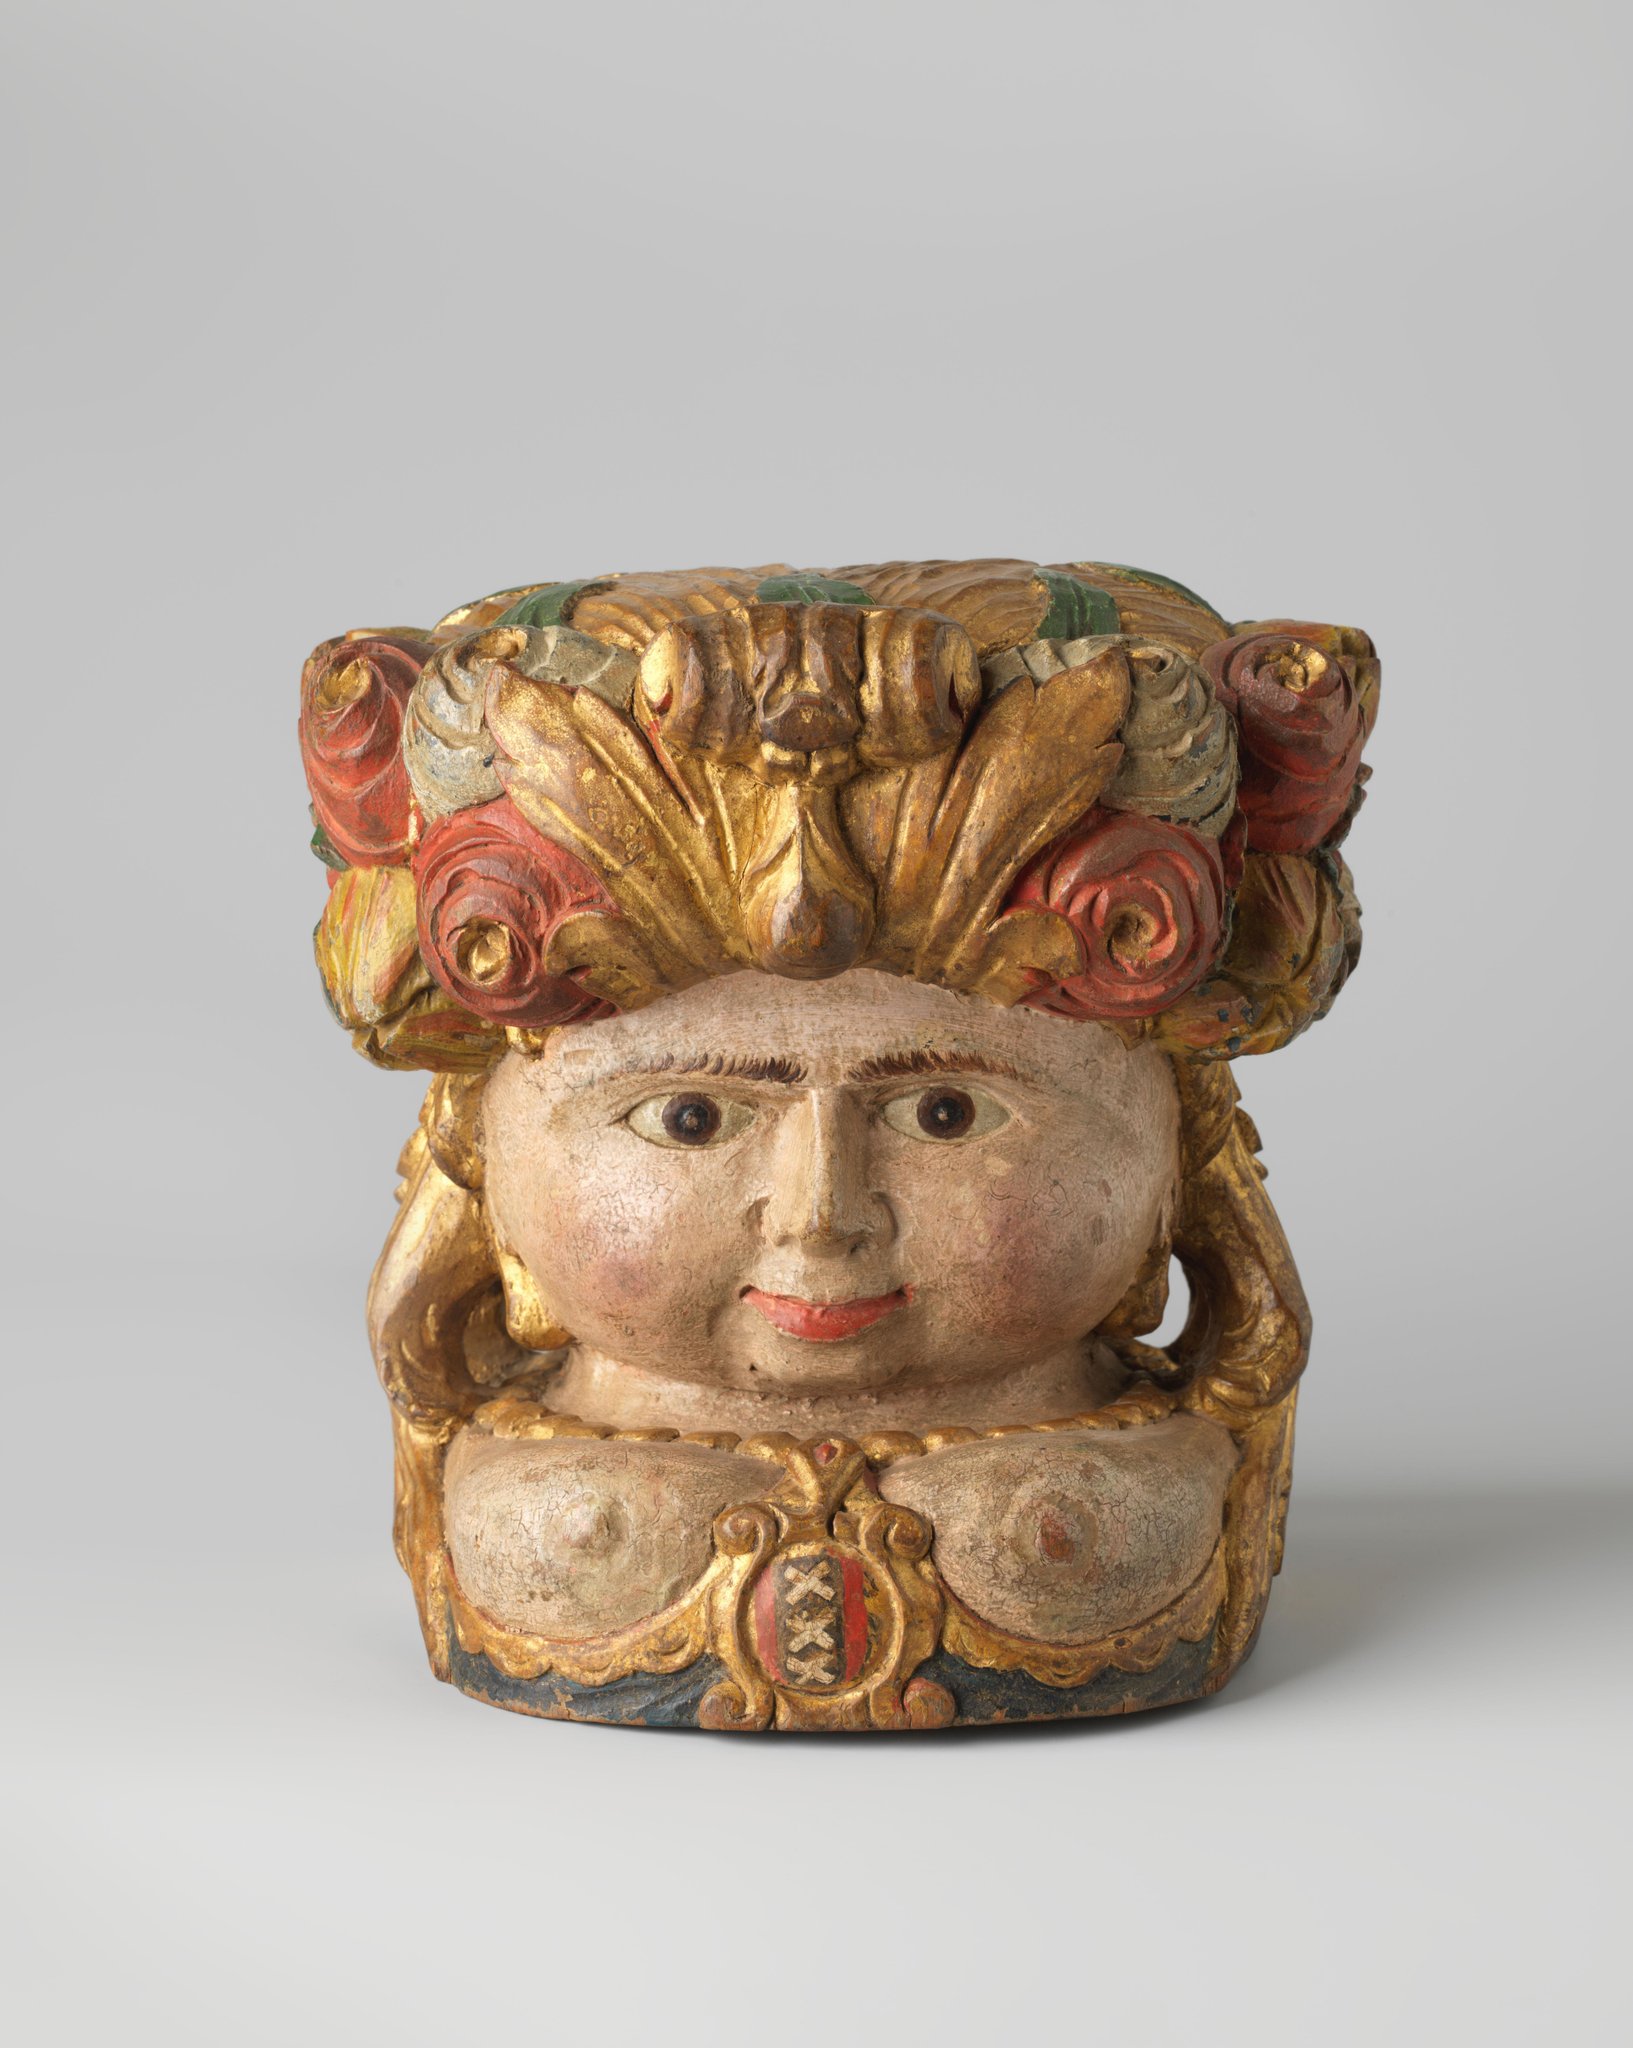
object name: roerkop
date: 1700-1800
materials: wood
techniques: cutting, polychromy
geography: netherlands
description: Roerkop, waarschijnlijk voorstellende het borstbeeld van Flora, Italische godin van de bloei van bloemen en veldgewas, zonder schouders, getooid met veelkleurige krans, om de hals een goudkleurige halsketting, tussen de borsten het wapen van Amsterdam. Het geheel staat ter bevestiging op een houten, ronde pin.